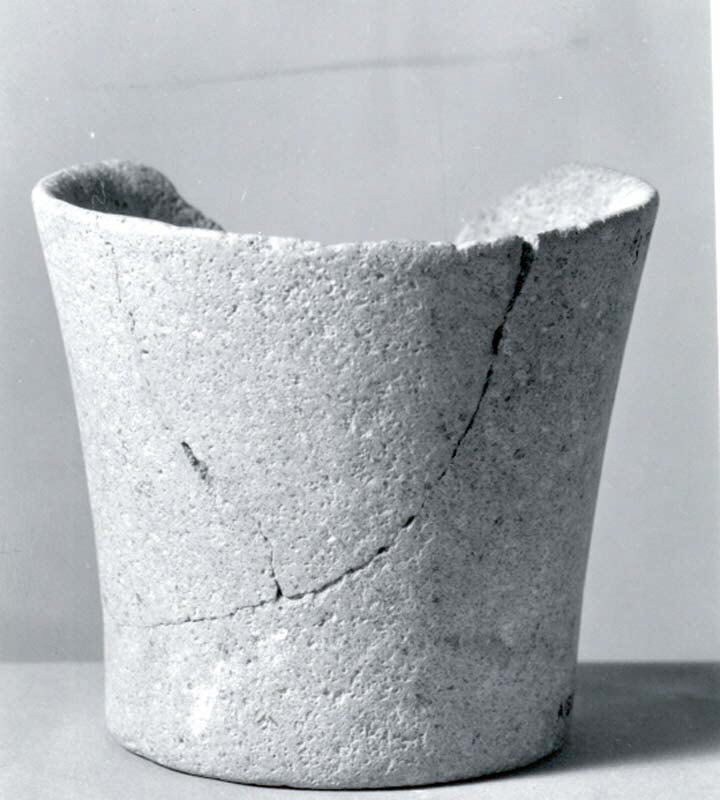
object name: vessel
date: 2700-2600 BCE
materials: stone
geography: mesopotamia